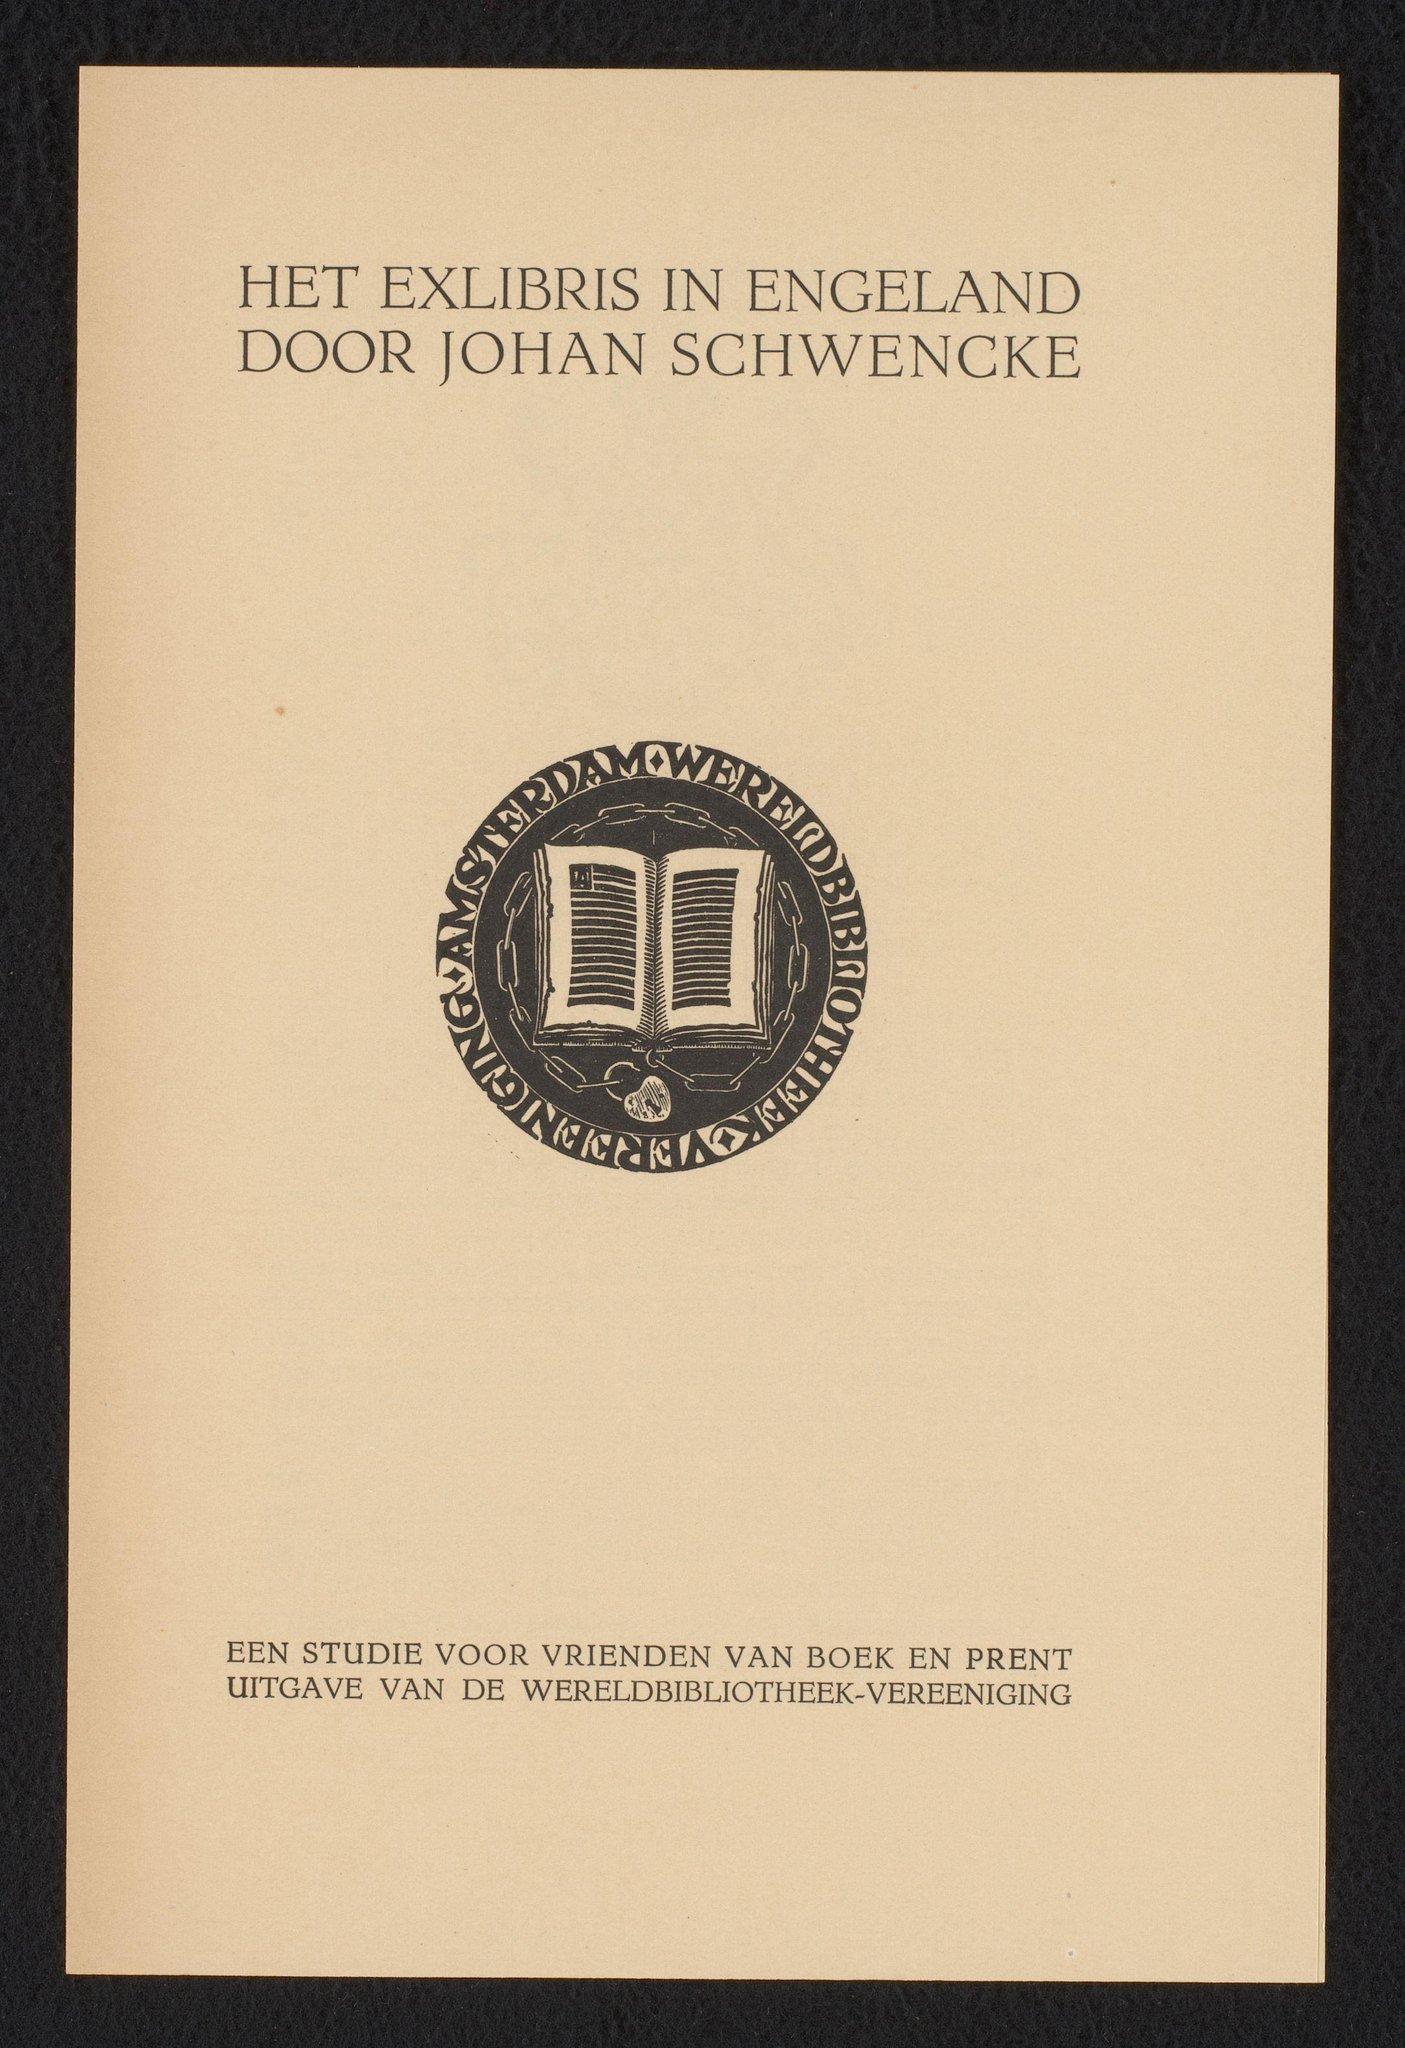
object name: prospectus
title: Prospectus voor: Johan Schwencke, Het exlibris in Engeland, 1936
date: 1936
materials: paper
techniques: letterpress printing, printing block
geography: amsterdam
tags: ex-libris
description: Op de voorzijde van het prospectus de titel en het vignet van de Wereldbibliotheek Vereeniging. Binnenin een reproductie van een heraldisch ex libris en beschrijvende tekst over de publicatie. Op de achterzijde een ex libris door N. Eekman en aanvullende details over de publicatie en uitgever.